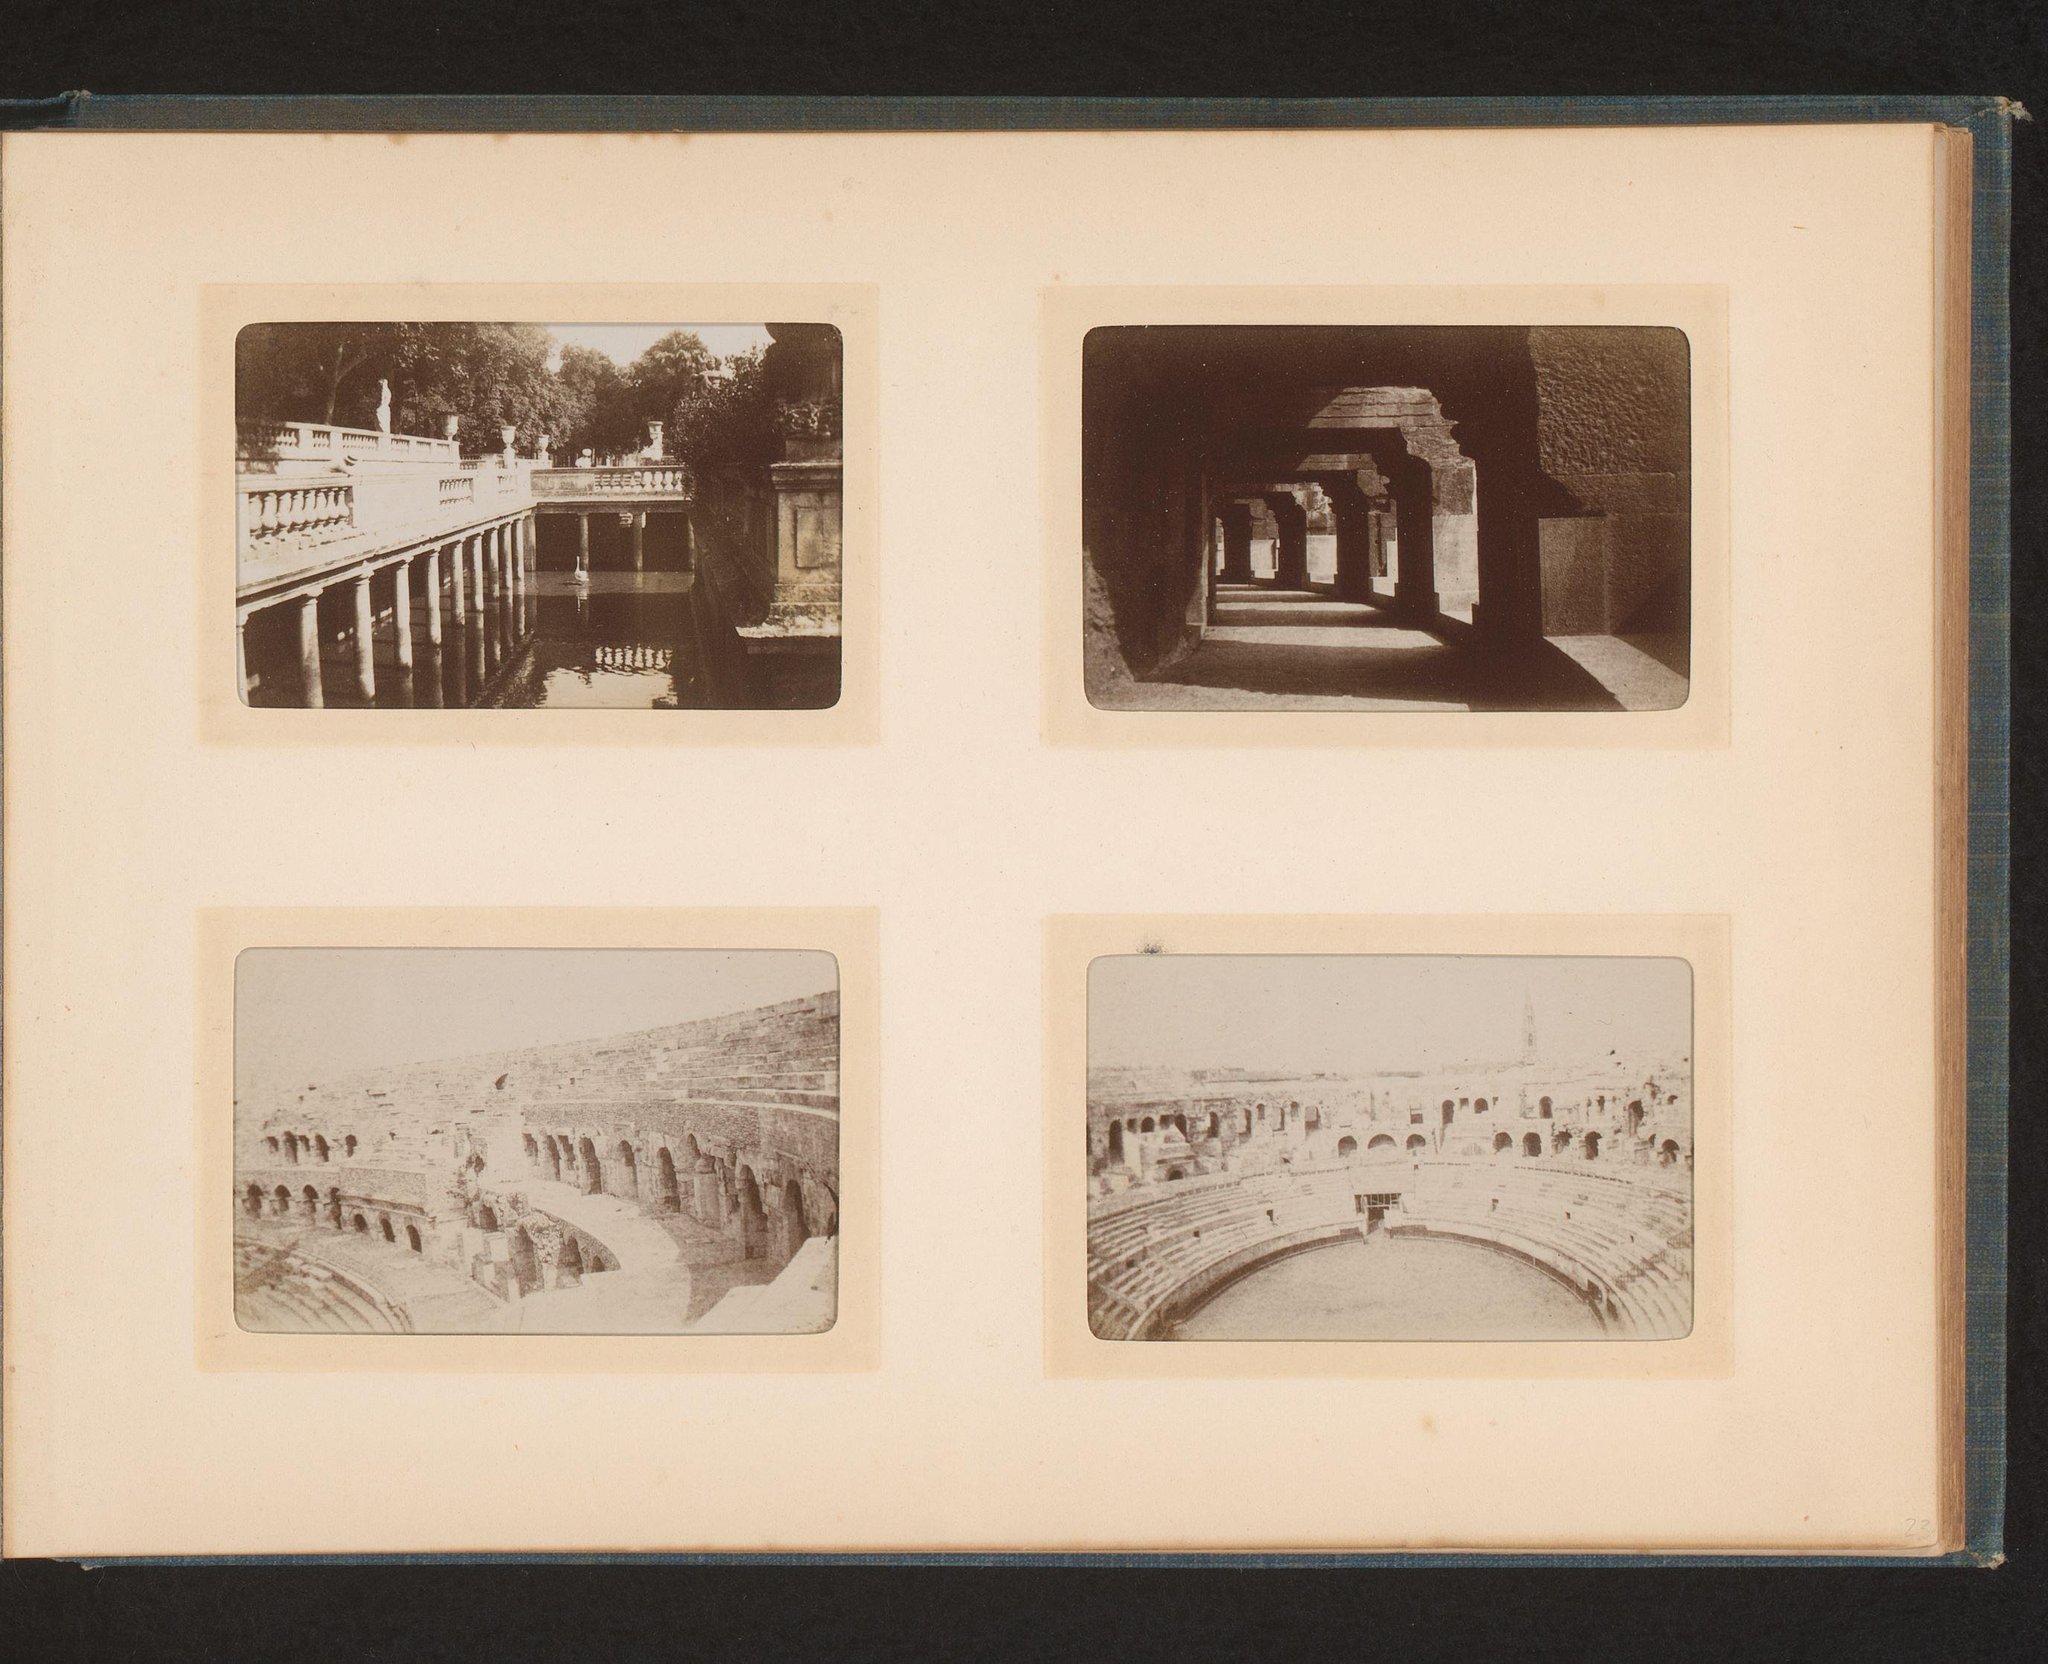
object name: photograph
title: Arena van het amfitheater te Arles, Doorgang van het amfitheater te Arles en Gezicht op een brug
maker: Anonymous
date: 1900-1915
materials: paper, photographic support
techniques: gelatin silver print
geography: france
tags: amphitheatre, travelling; tourism, bridge, france